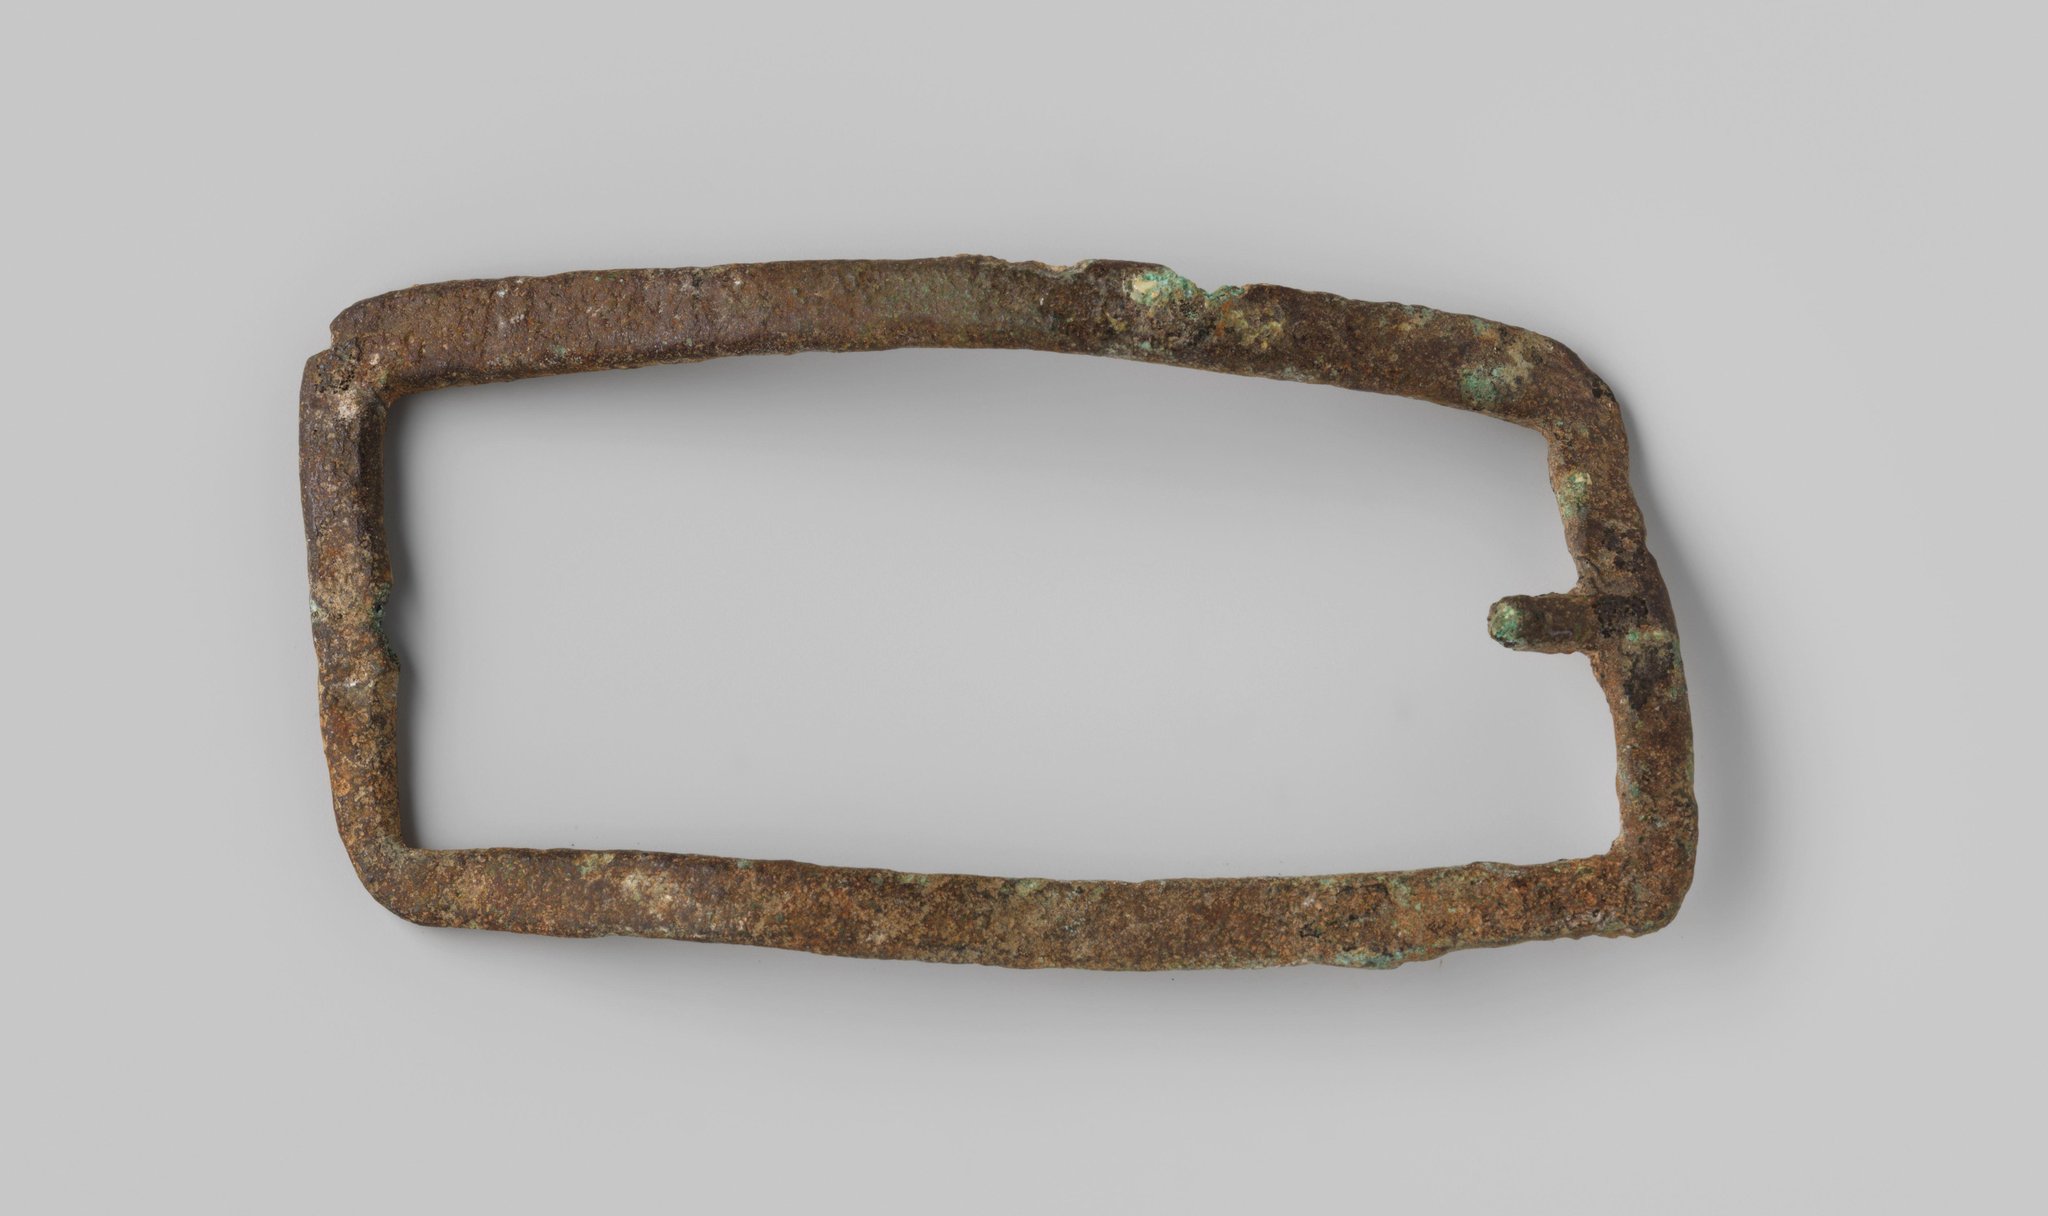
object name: belt buckle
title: Fragment riemgesp uit het wrak van de Oost-Indiëvaarder Hollandia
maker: Anonymous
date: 1700-1743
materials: copper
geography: netherlands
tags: verenigde oostindische compagnie, hollandia (schip), annet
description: Rectangular, ring, spindle eroded, id. NG 1980-27H2852, belt buckle.